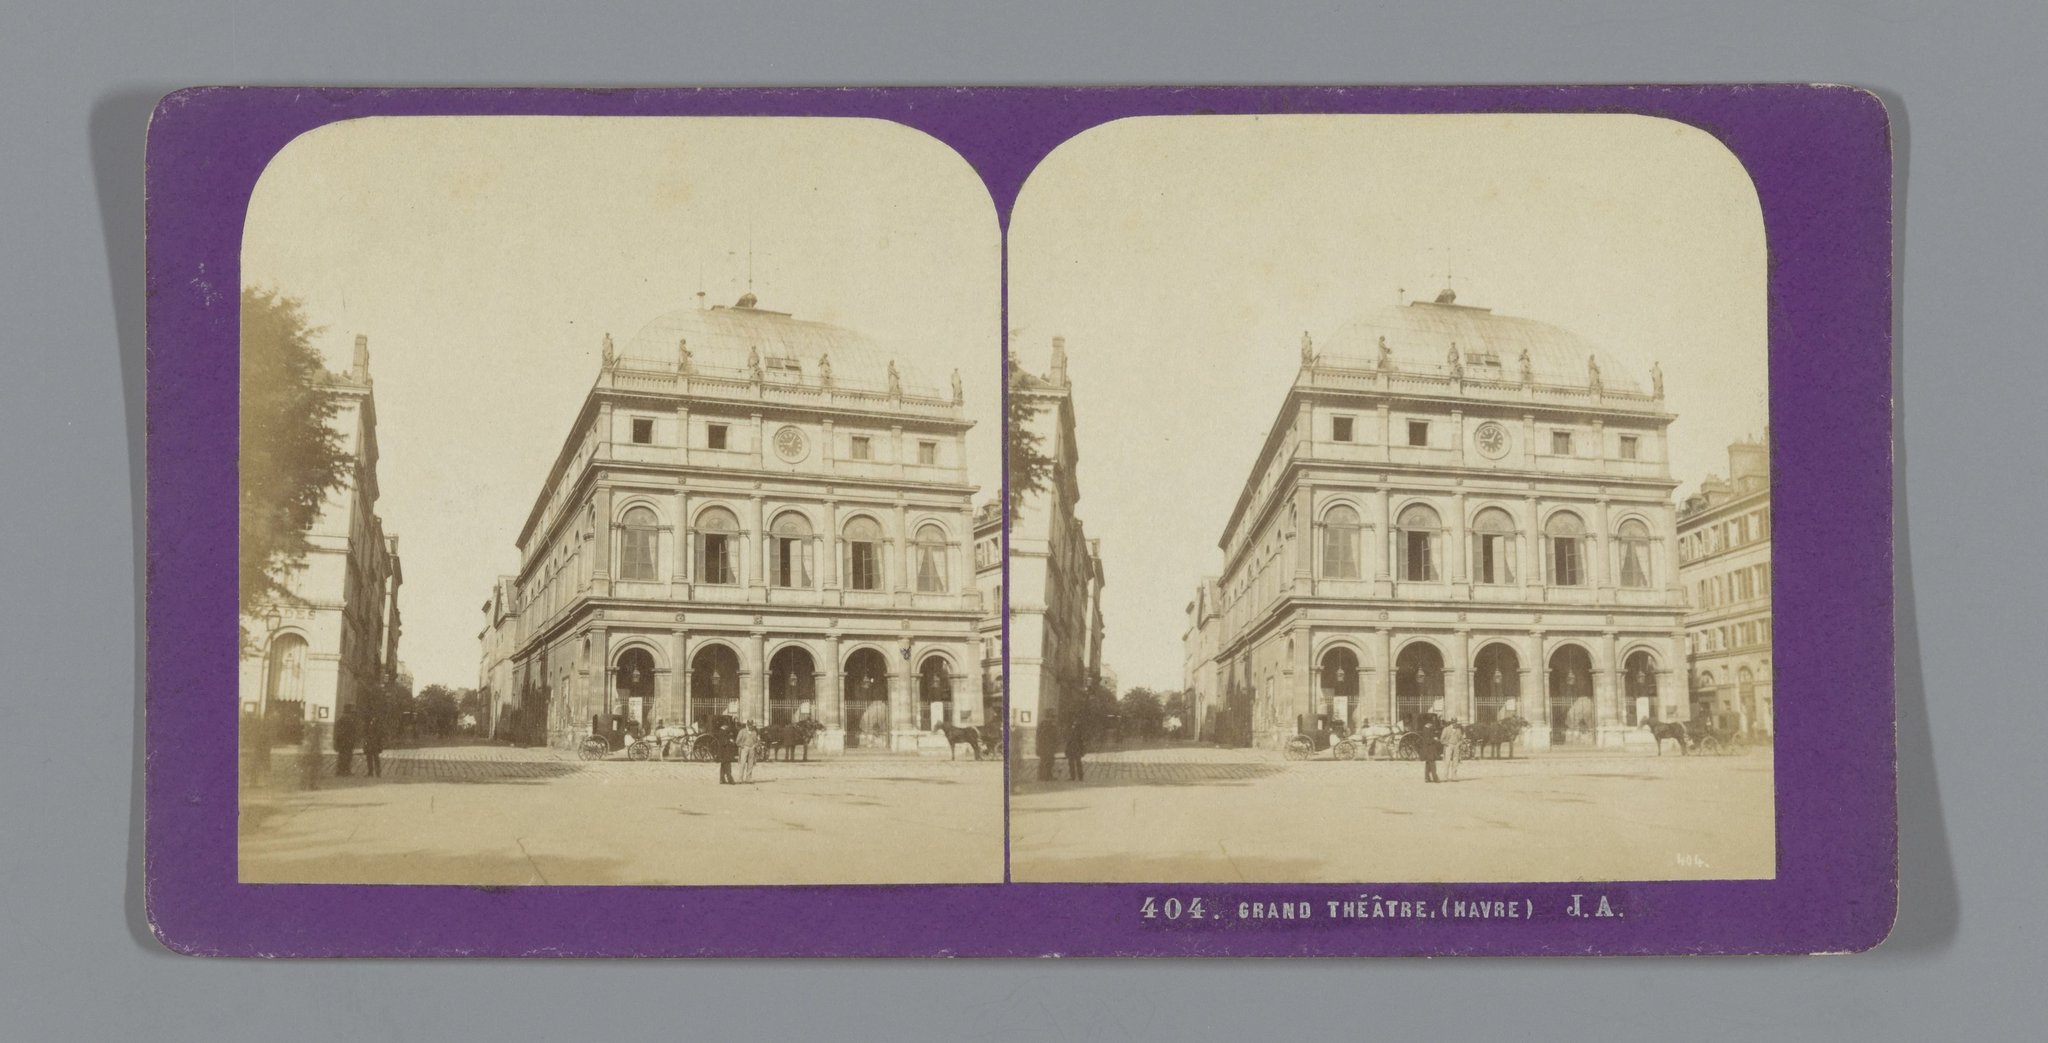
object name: stereograph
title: Grand Théâtre (Havre)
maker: jean andrieu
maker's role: fotograaf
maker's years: 1816-1872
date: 1862-1876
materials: cardboard, photographic support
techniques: albumen print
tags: theatre (building), façade (of house or building)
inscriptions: number: ‘404.’